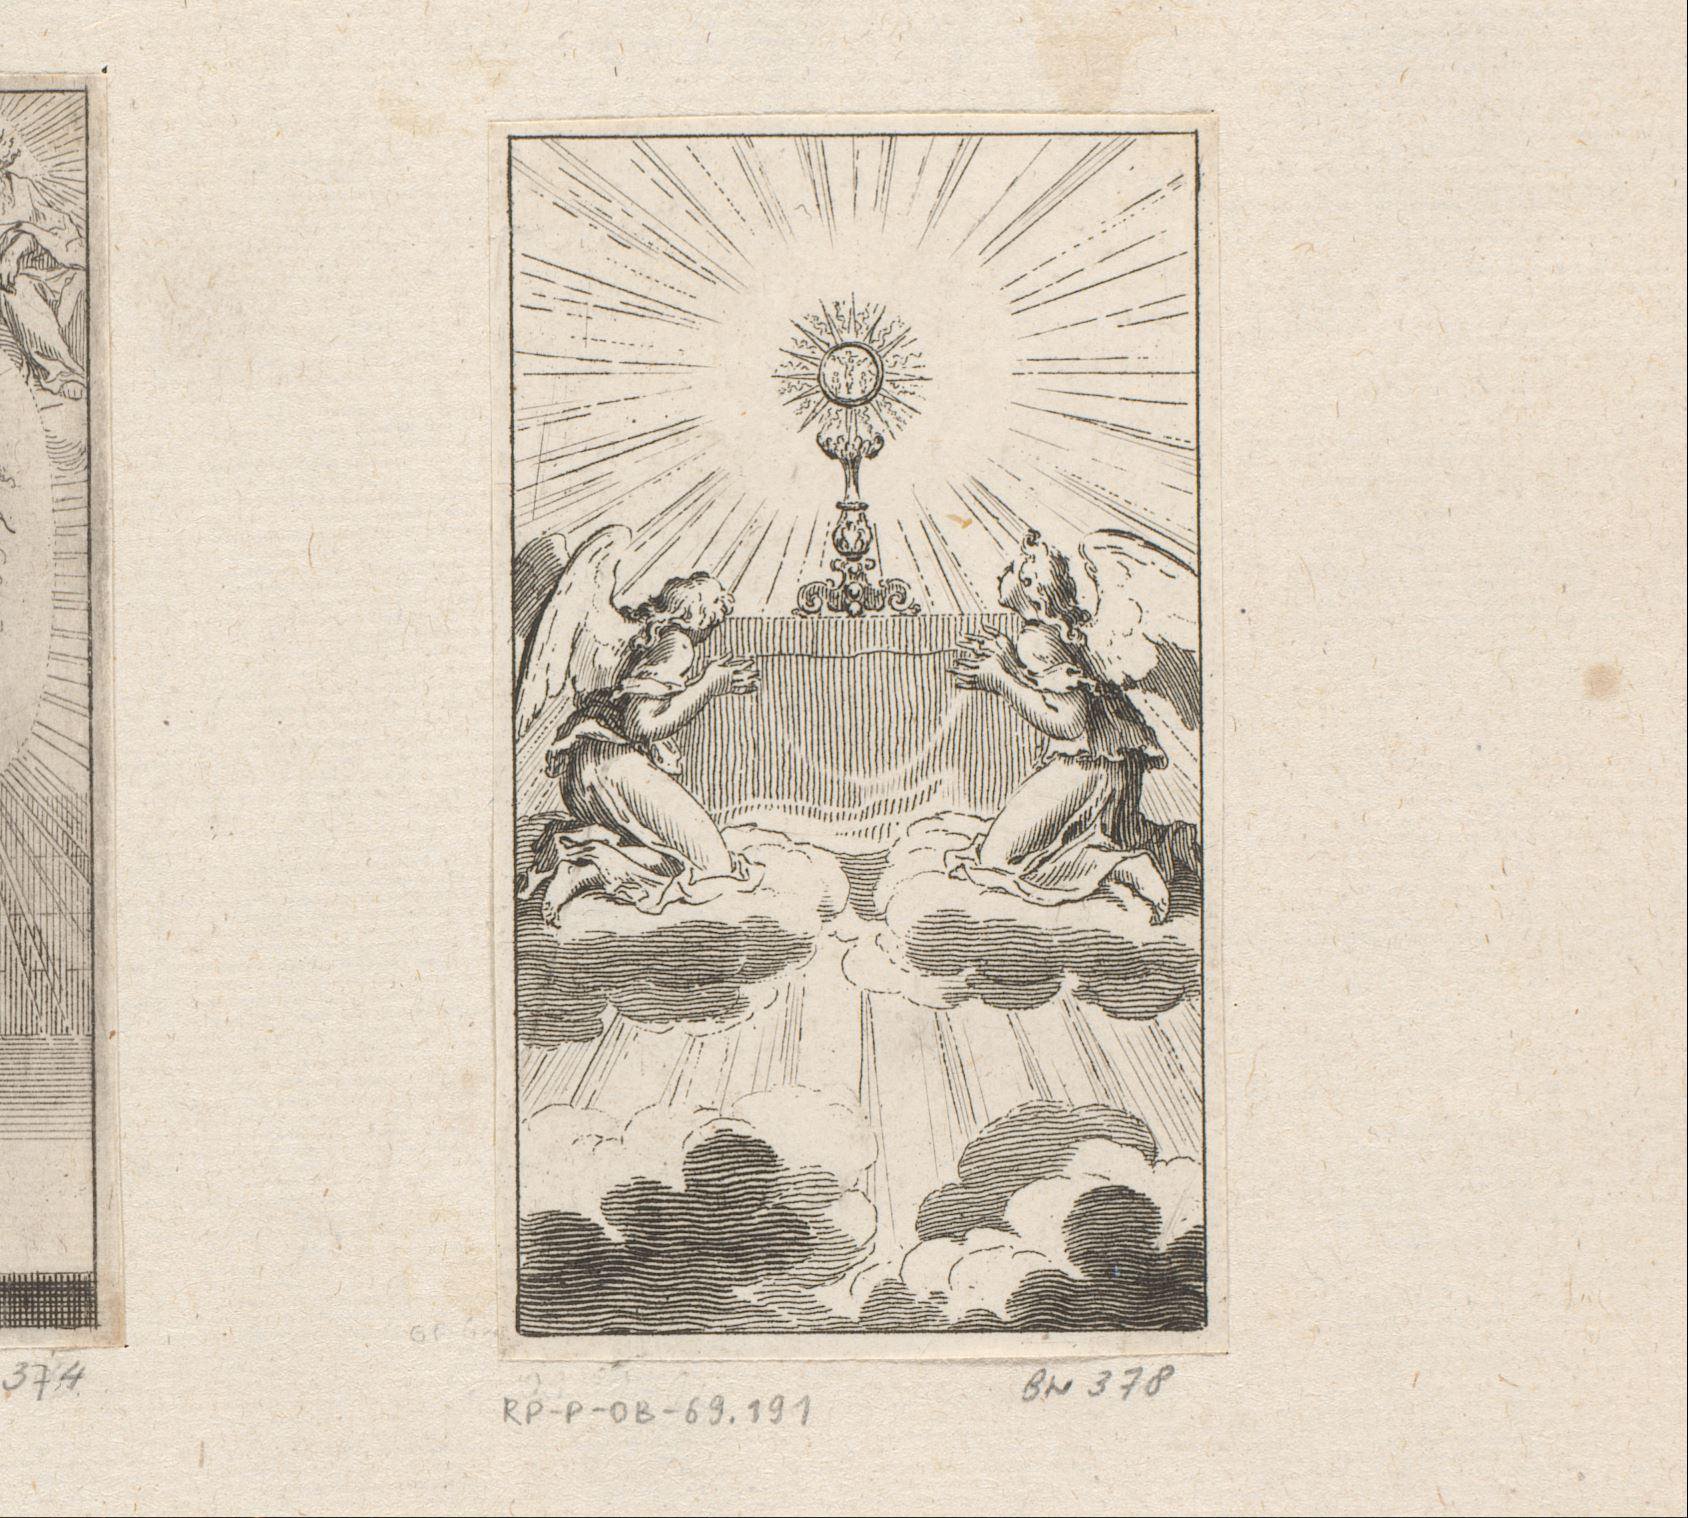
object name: print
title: Twee engelen bij een monstrans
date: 1683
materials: paper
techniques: etching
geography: france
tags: ostensorium, monstrance, angels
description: Prent uit: Heures dédiées à la Dauphine. Metz: François Bouchard, 1683.